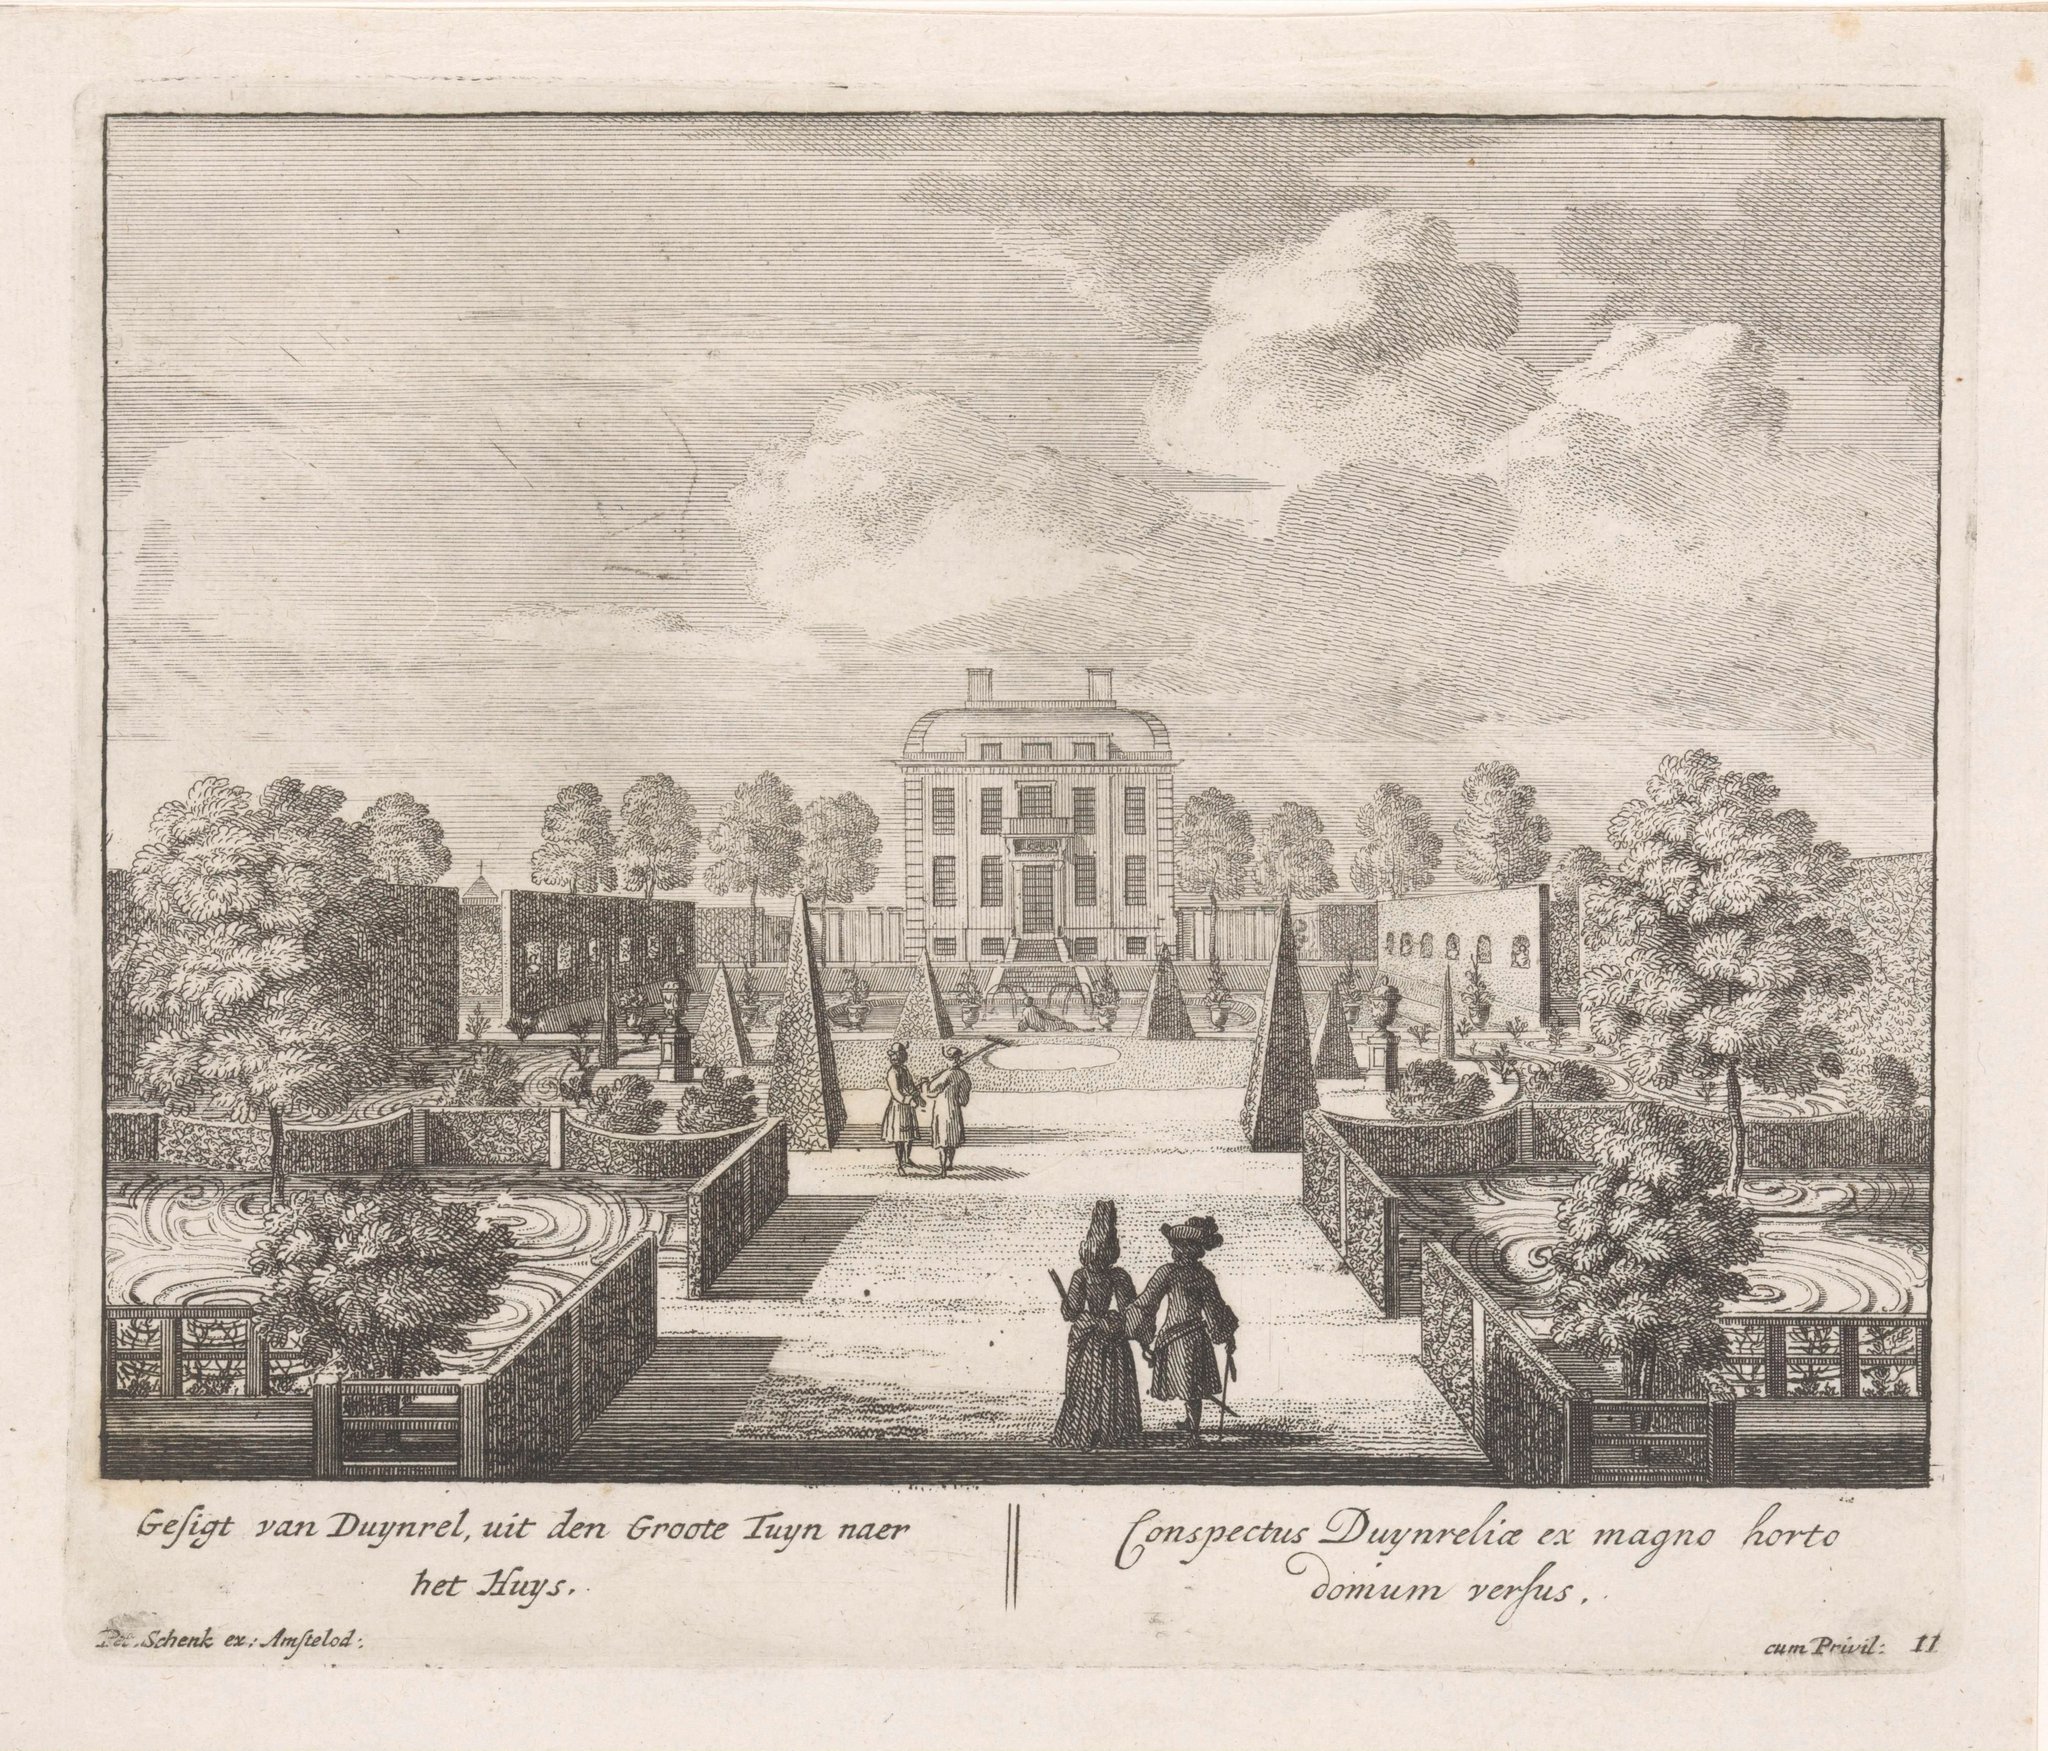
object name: print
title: Gezichten op de buitenplaats Duinrell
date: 1675-1711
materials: paper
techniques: etching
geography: amsterdam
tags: french or architectonic garden; formal garden, country-house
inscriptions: collector's mark: Lugt 2228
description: Gezicht op het huis van buitenplaats Duinrell, gezien vanuit de tuin. Op de achtergrond het huis en de vijver met fonteinen. In de tuin enkele figuren. Rechtsonder genummerd: 11. Prent uit een serie van zestien prenten van Duinrell.